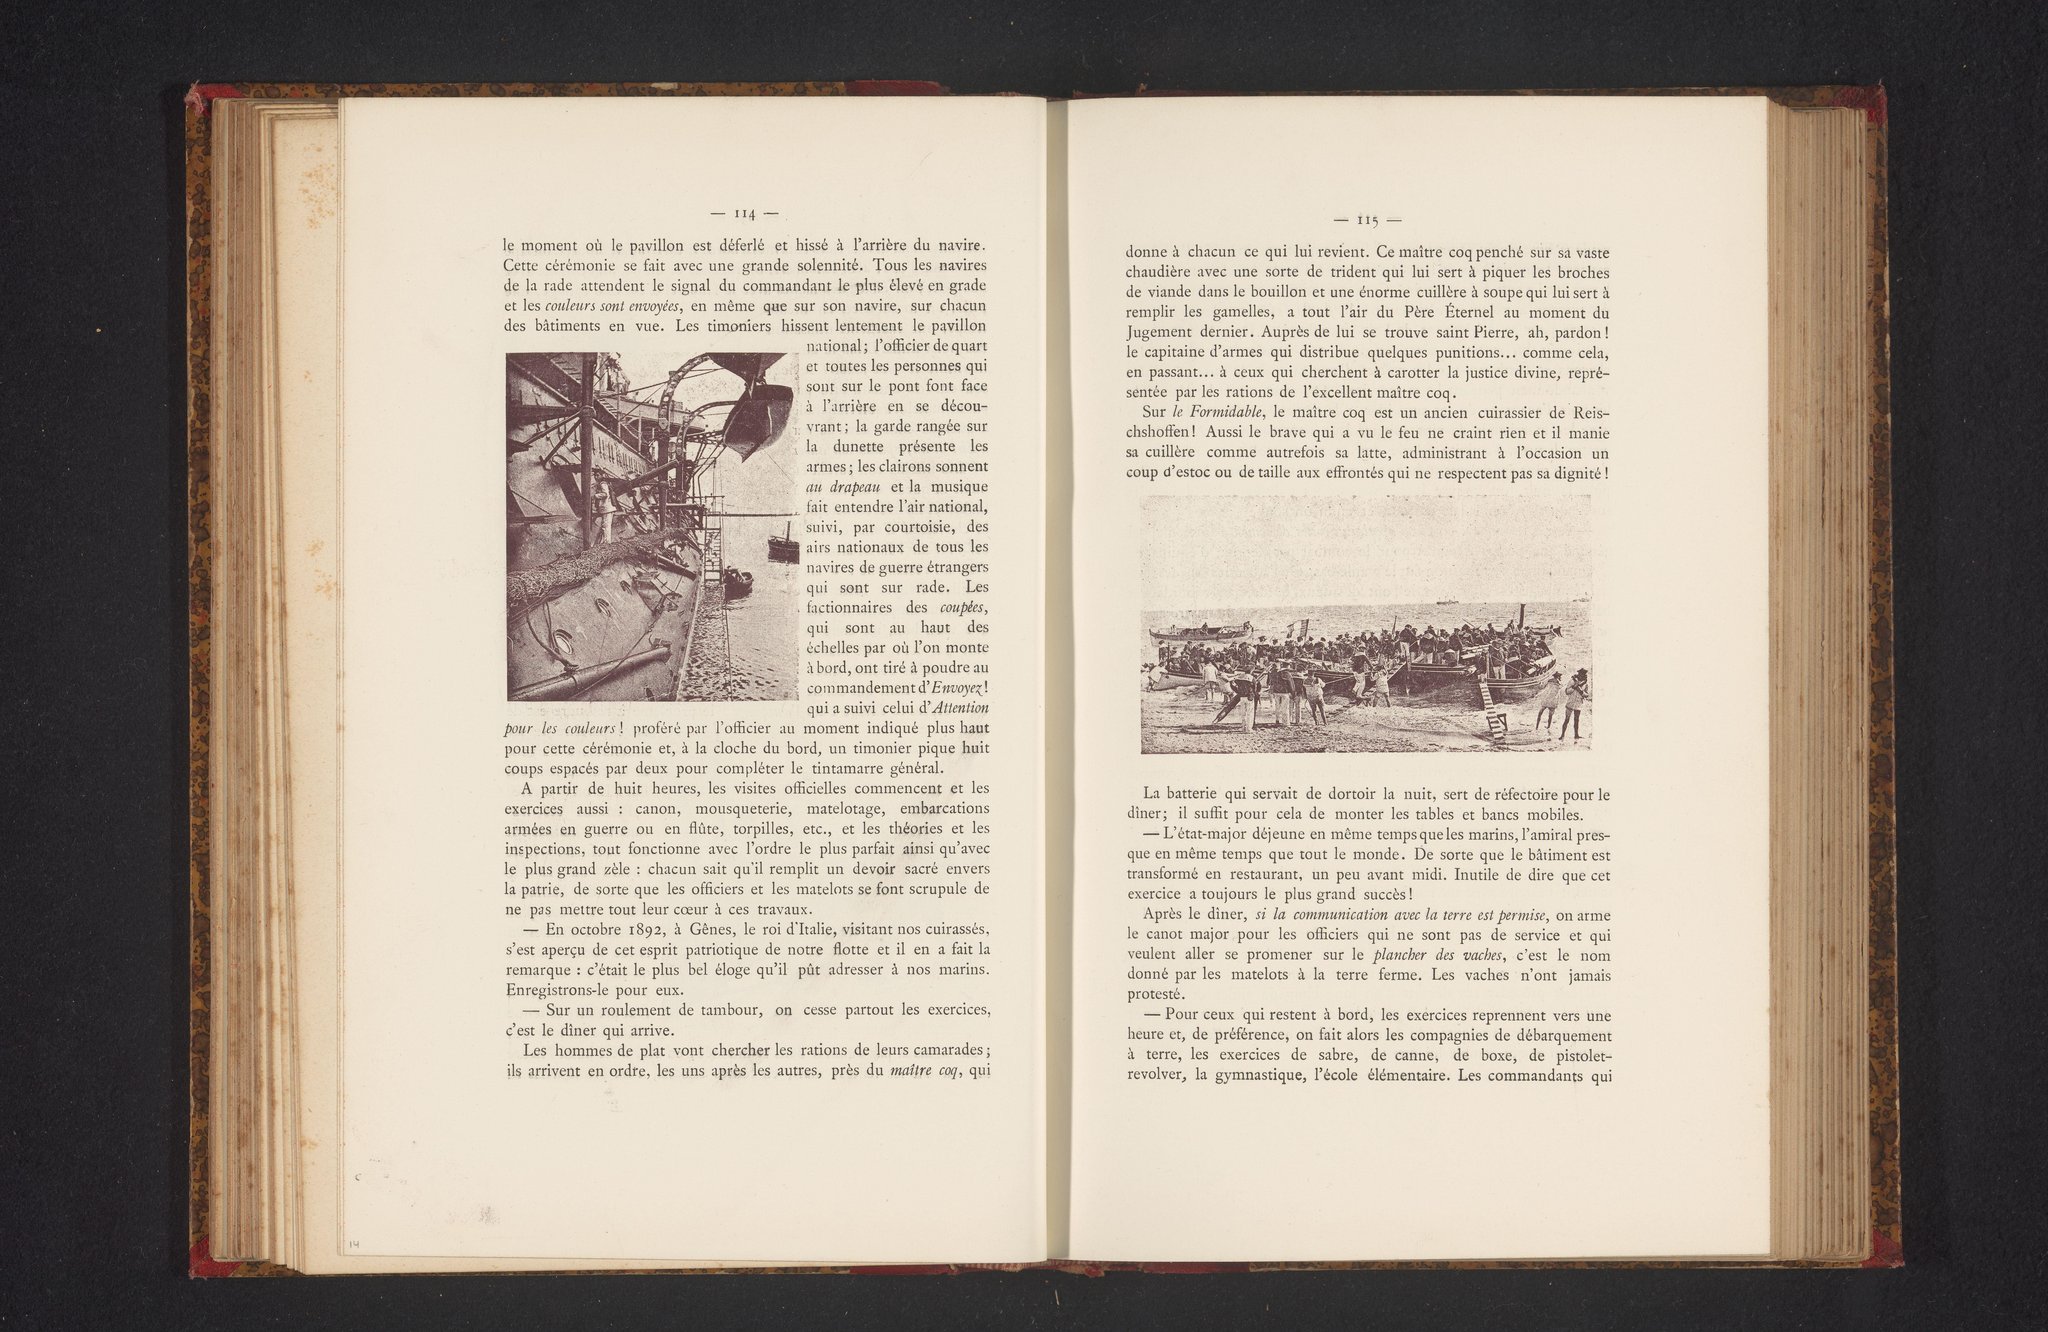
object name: page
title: Matrozen betreden sloepen vanaf het strand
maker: Anonymous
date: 1888-1893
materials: paper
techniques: photograph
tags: crew ~ ship, sailing-ship, sailing-boat (with name)